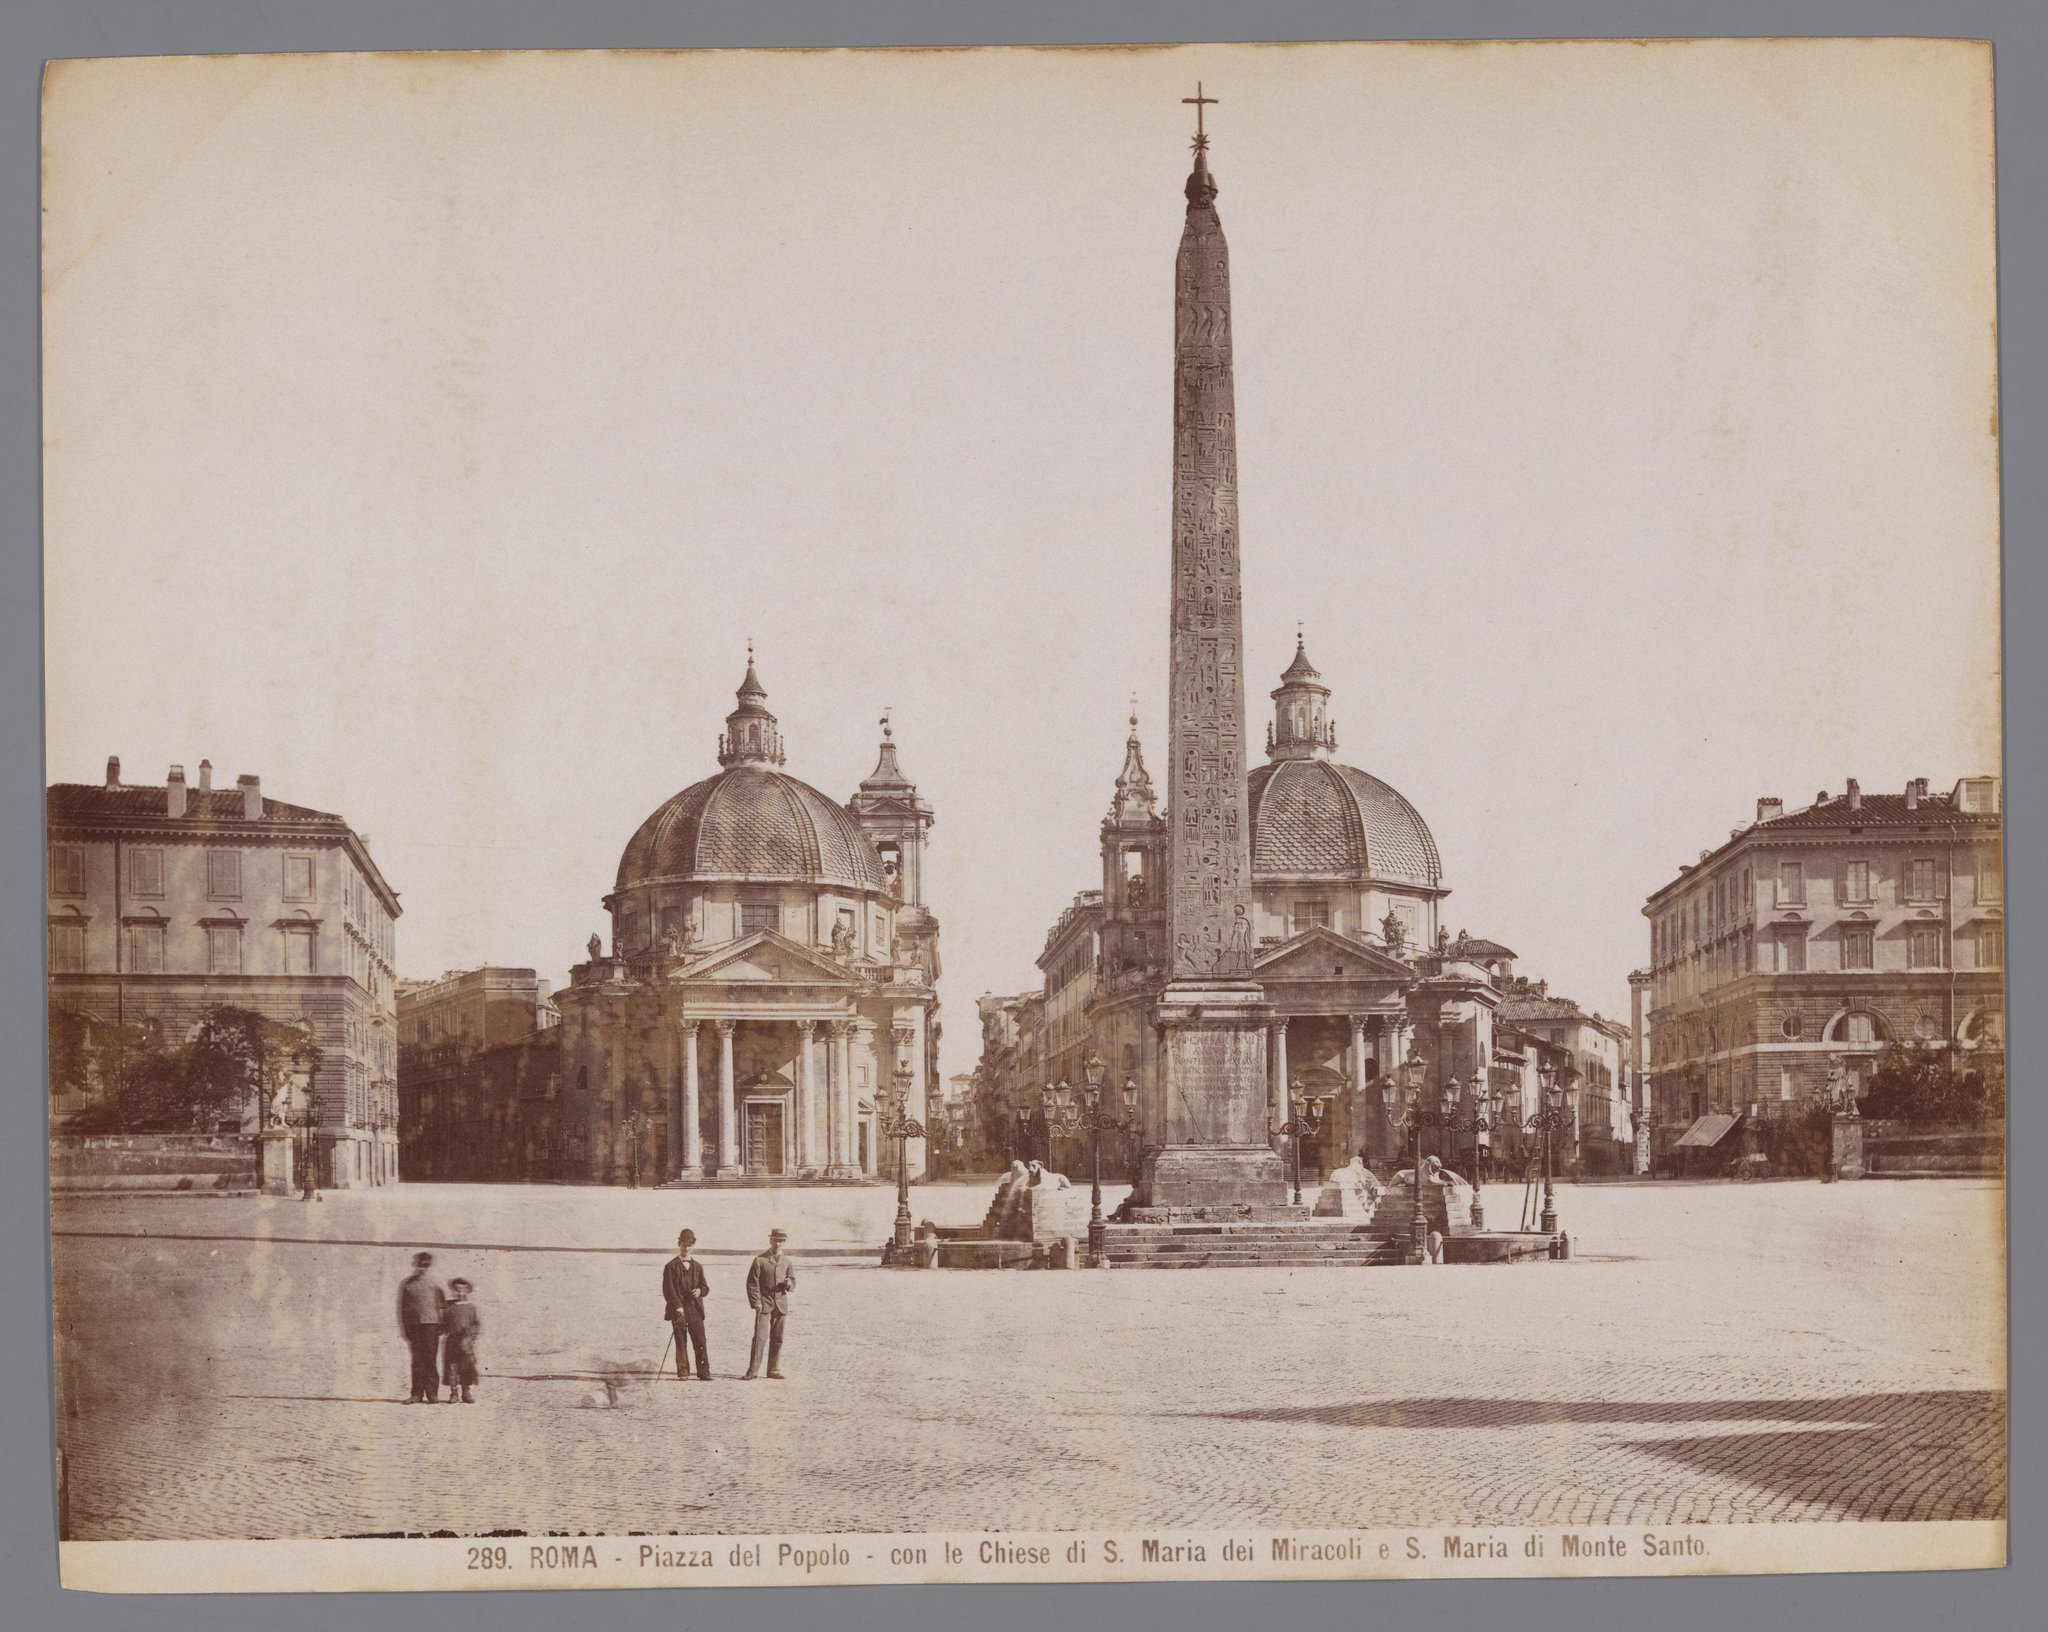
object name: photograph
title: Gezicht op het Piazza del Popolo te Rome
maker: Anonymous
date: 1851-1900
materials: paper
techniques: albumen print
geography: rome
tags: obelisk, needle, church (exterior), village square, place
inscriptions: number: ‘289.’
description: Aan de achterzijde van het plein zijn de Santa Maria dei Miracoli en de Santa Maria in Montesanto te zien.